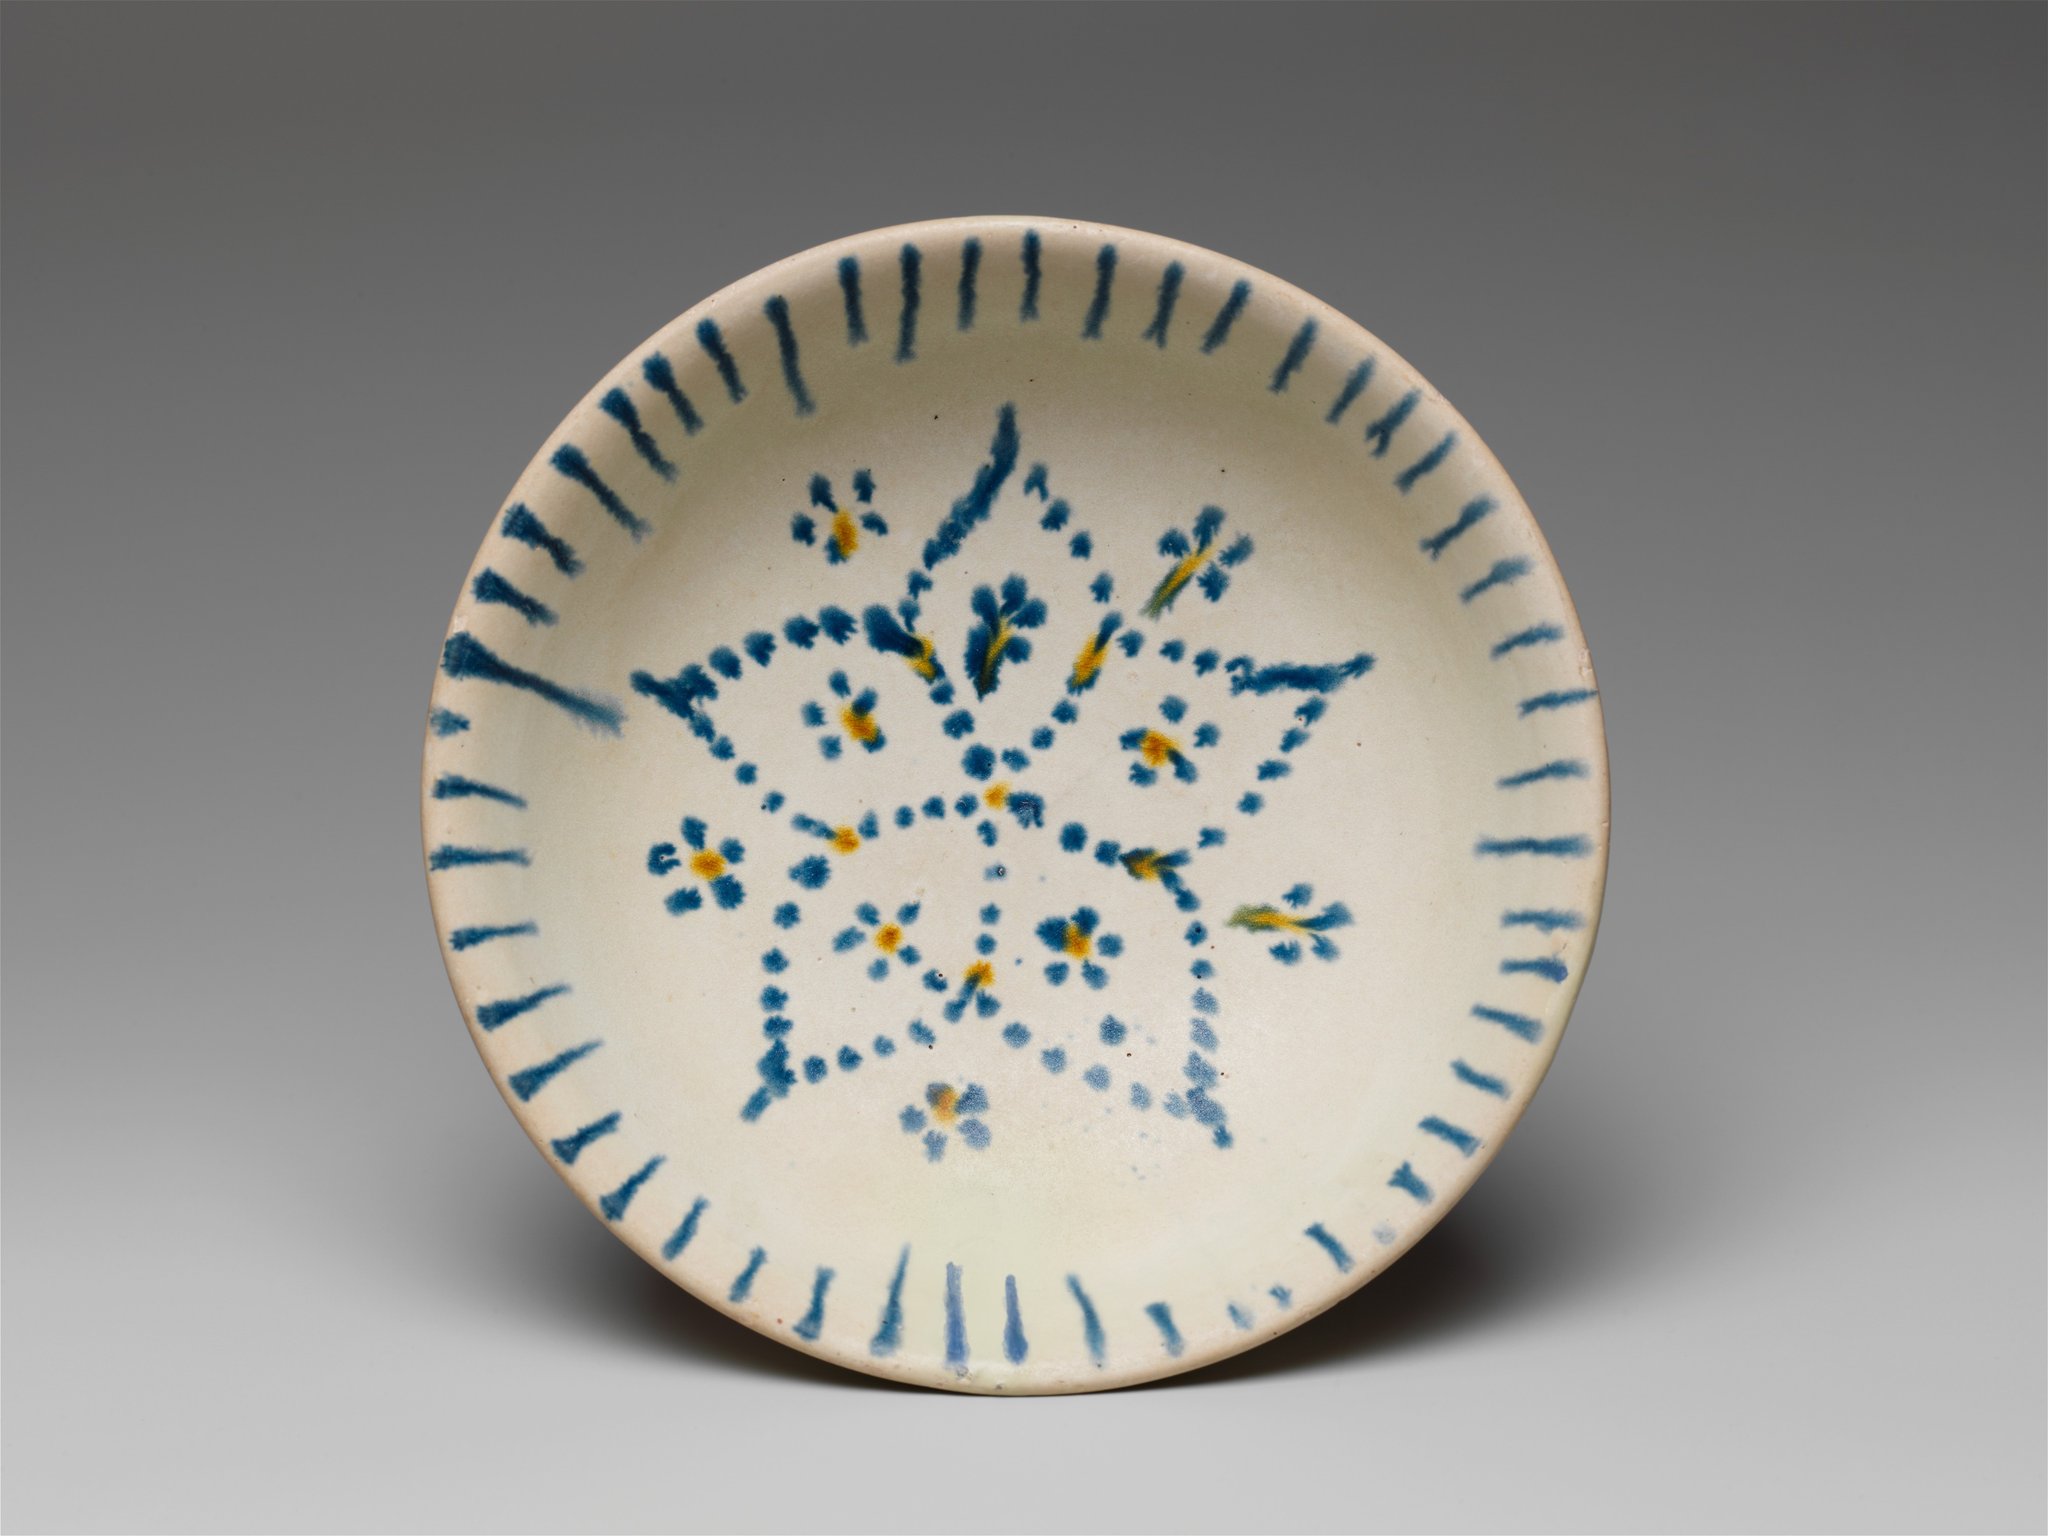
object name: bowl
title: Bowl with five petaled flower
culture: chinese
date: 618-907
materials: earthenware, glaze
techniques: painting